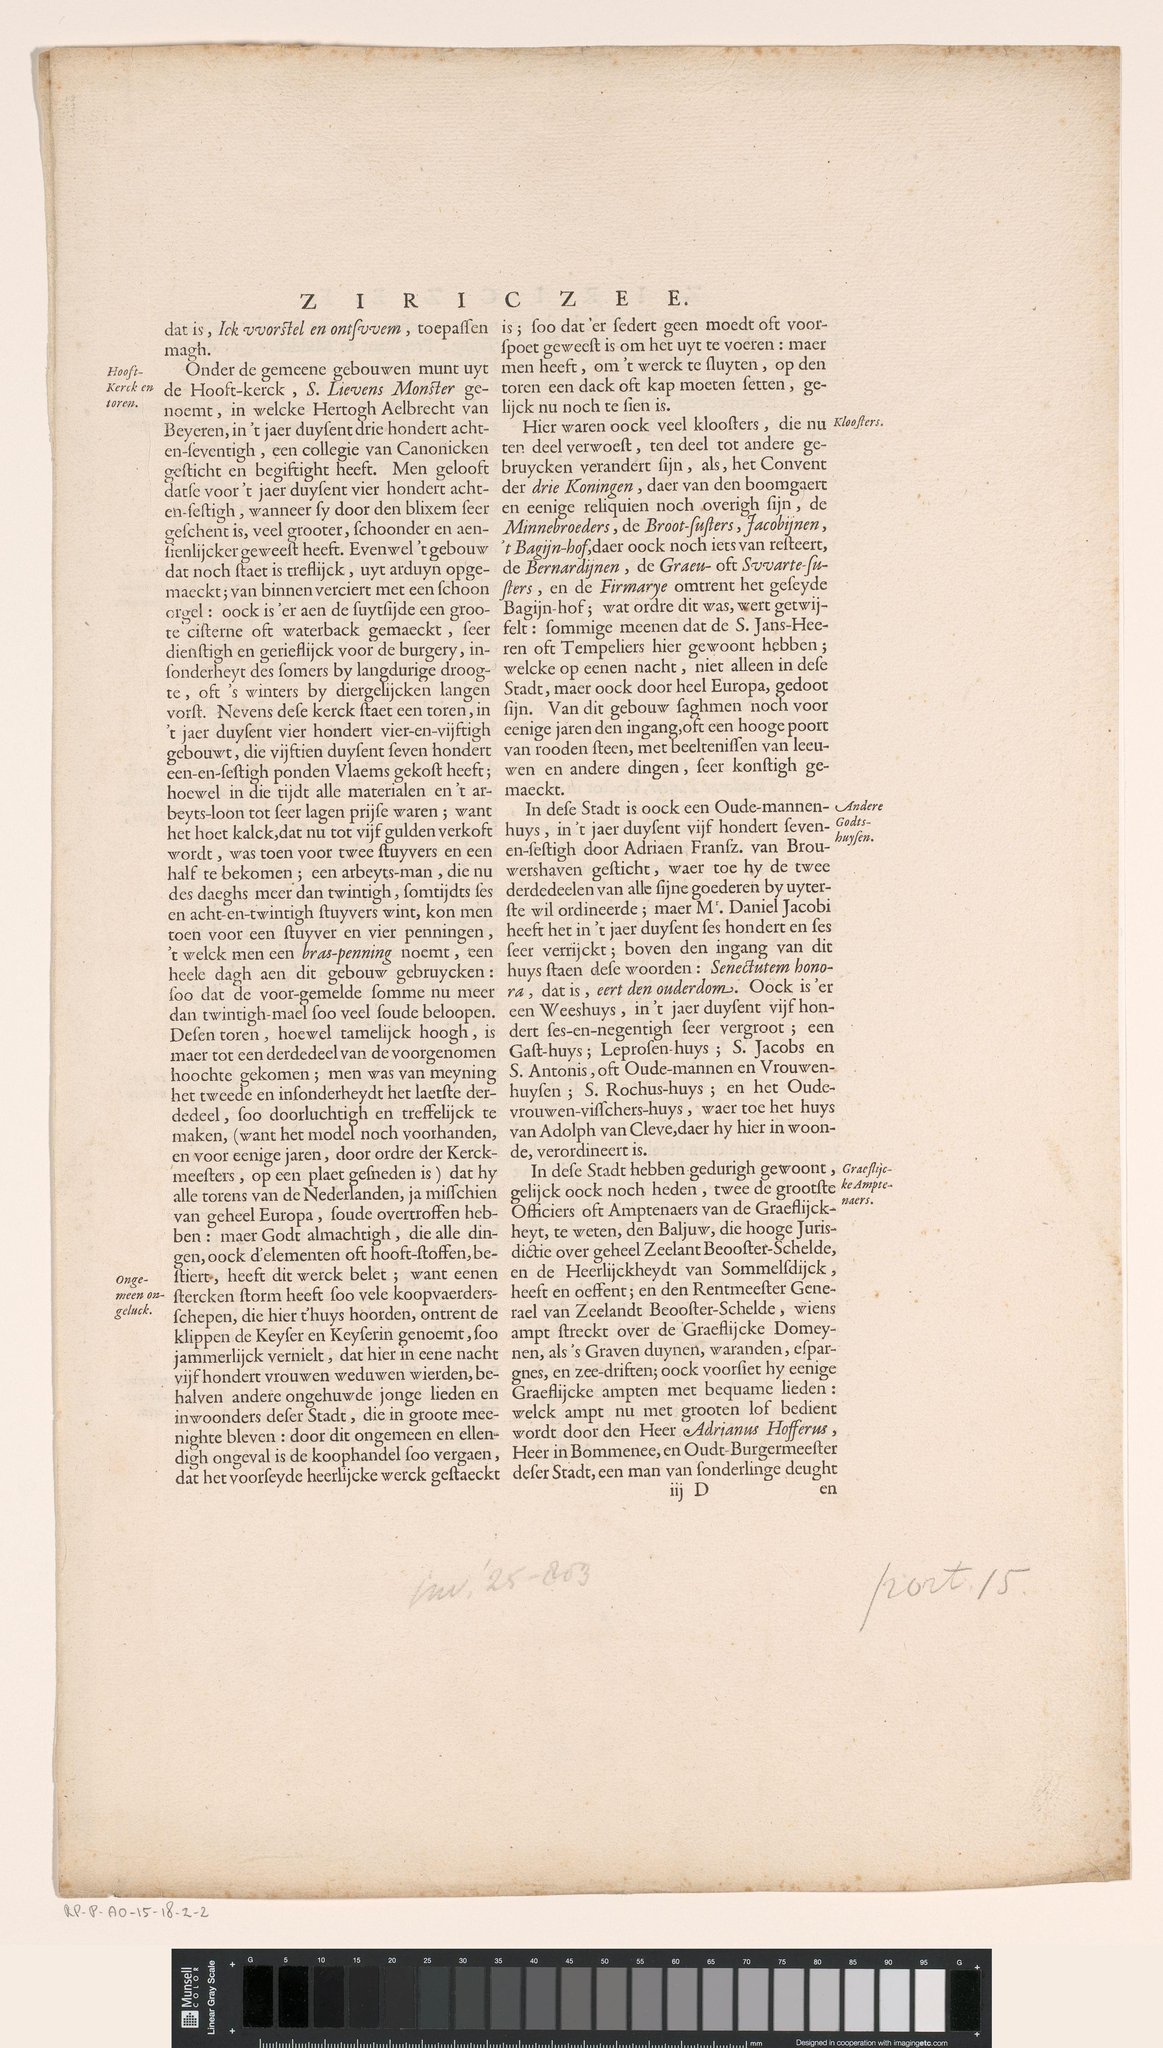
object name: text sheet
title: Deel van een beschrijving van de stad Zierikzee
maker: johannes willemszoon blaeu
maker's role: printer, publisher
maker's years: 1596-1673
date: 1652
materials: paper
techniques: letterpress printing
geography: amsterdam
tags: zierikzee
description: Tekst gebruikt in: Blaeu, Johannes Willemszoon. Toonneel der steden van de Vereenighde Nederlanden. 2 delen. Amsterdam: Johannes Willemszoon Blaeu, 1652, dl. 1. Zie RP-P-AO-15-18-2-1 voor de plattegrond die ook in deze atlas is gebruikt.